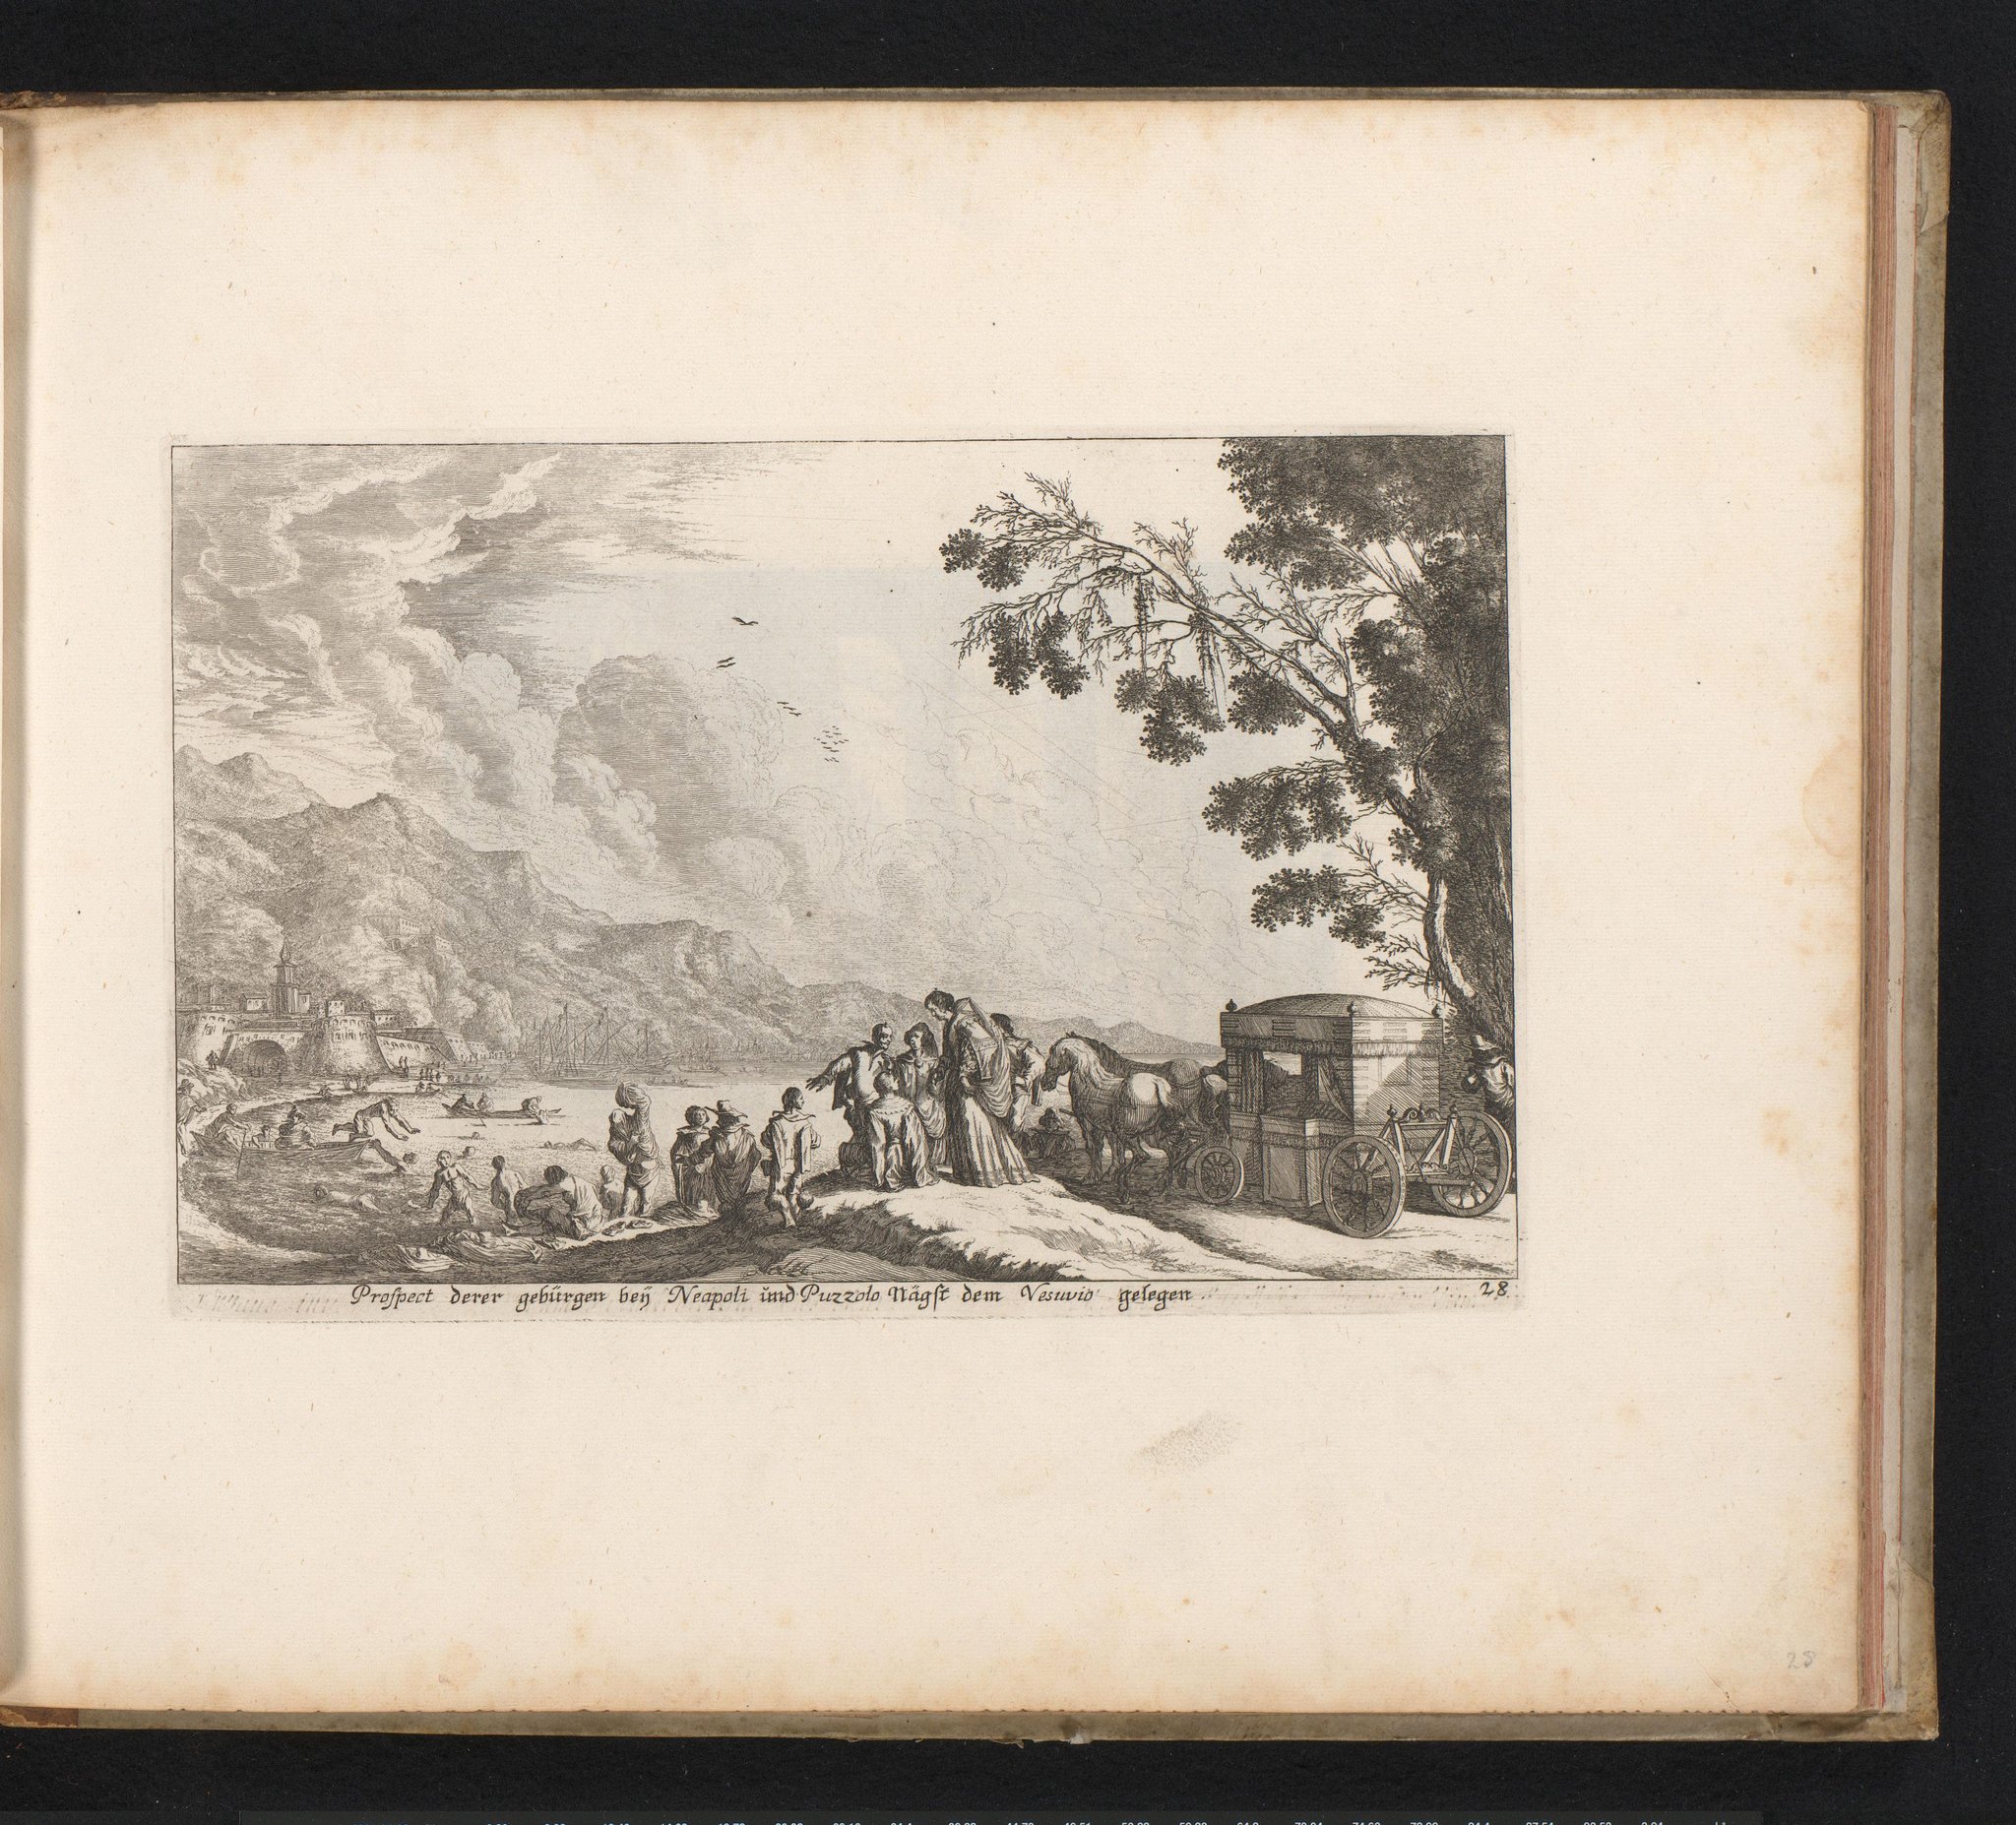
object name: album leaf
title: Gezicht op de kust bij Napels en de Vesuvius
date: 1670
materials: paper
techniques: etching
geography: augsburg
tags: mound, verge (+ landscape with figures, staffage), passenger carriage (+ four persons or more ~ traffic and transport), volcano, mount vesuvius, naples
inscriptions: collector's mark: Lugt 2228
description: Tekst in het Duits in de ondermarge. Rechtsonder genummerd: 28. Prent maakt deel uit van een album.